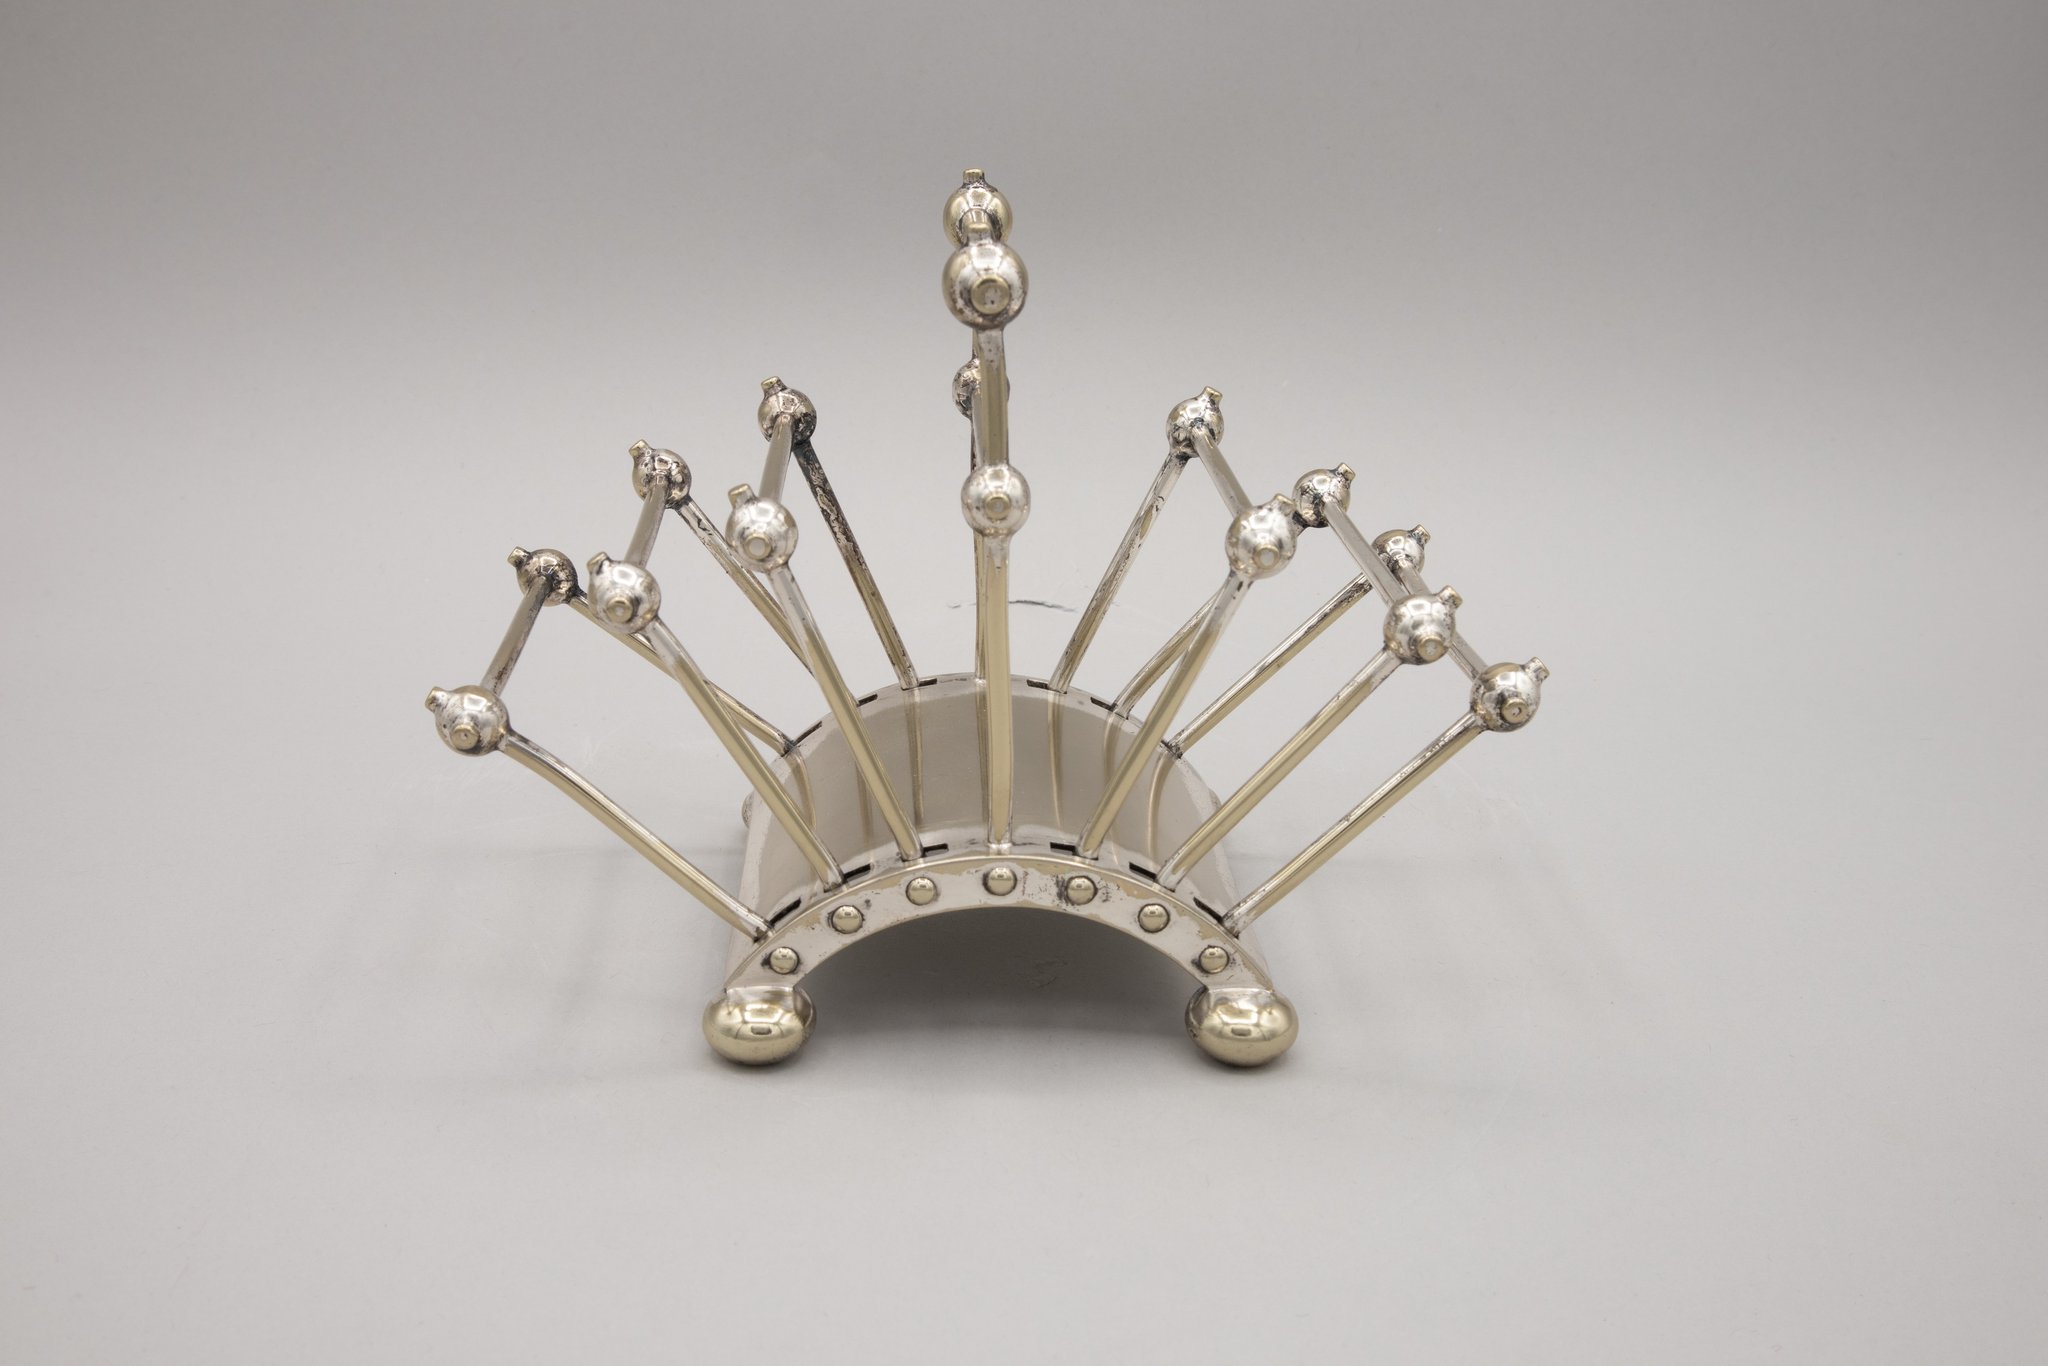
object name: toast or letter rack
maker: christopher dresser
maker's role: designer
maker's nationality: british, scottish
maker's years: 1834-1904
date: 1881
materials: silver